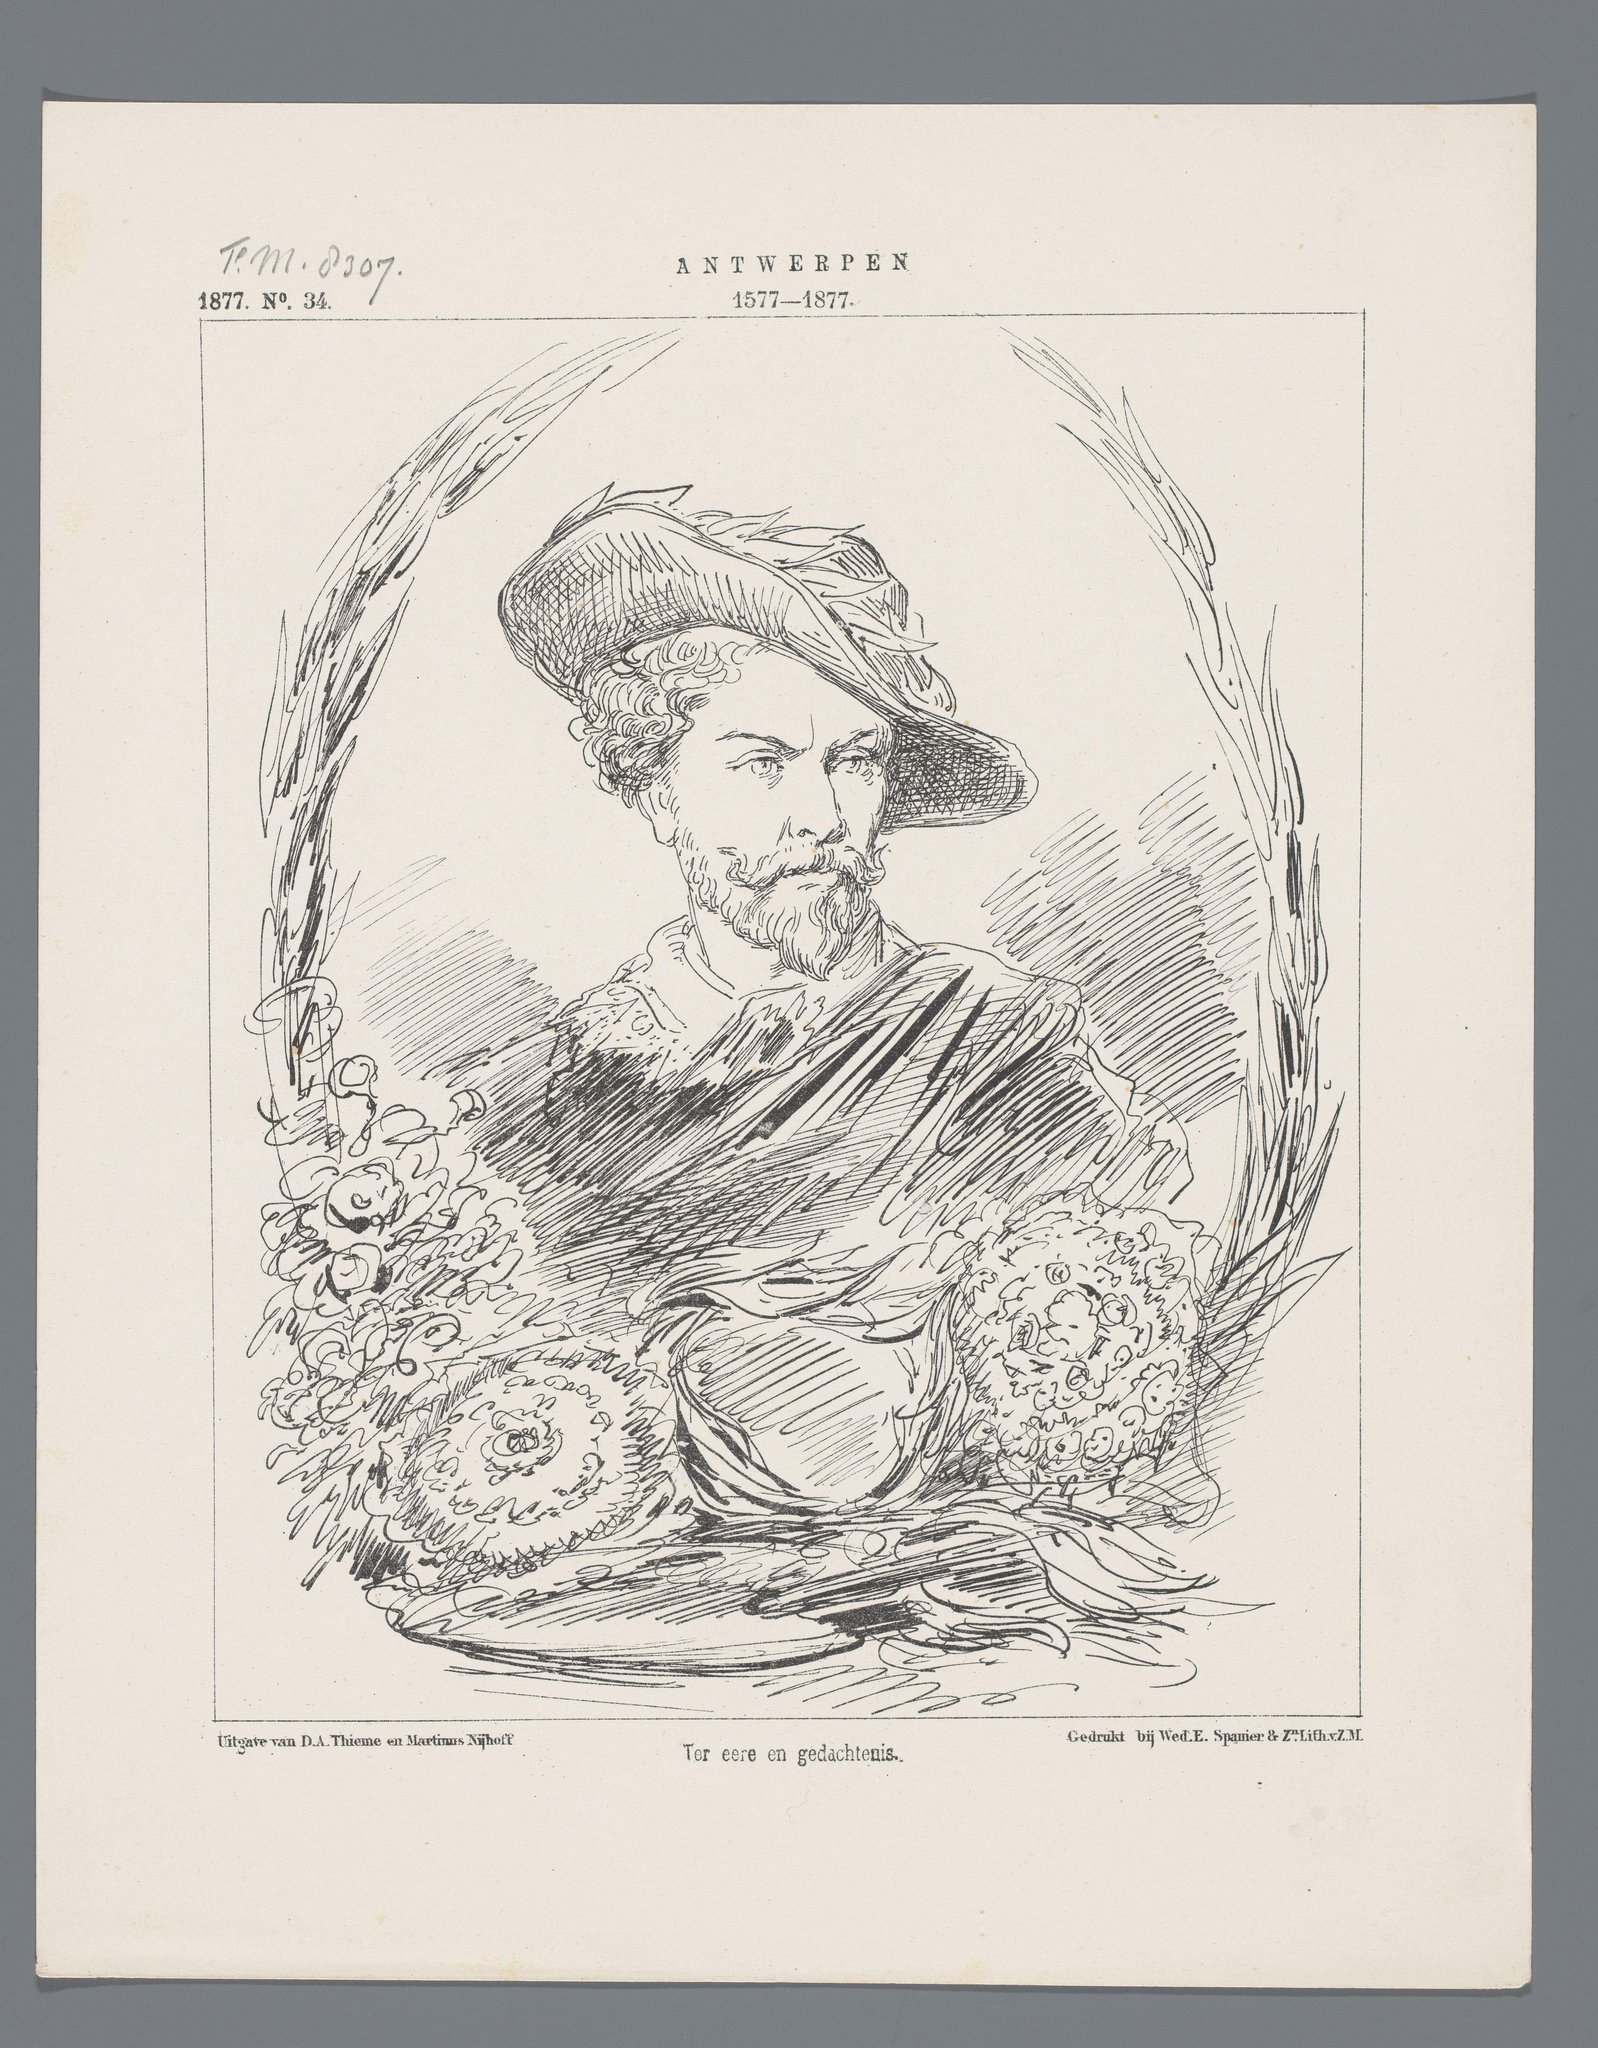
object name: print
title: Antwerpen 1577-1877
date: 1877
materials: paper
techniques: lithograph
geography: netherlands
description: Plaat verschenen bij het weekblad De Nederlandsche Spectator, nr. 34, 1877.